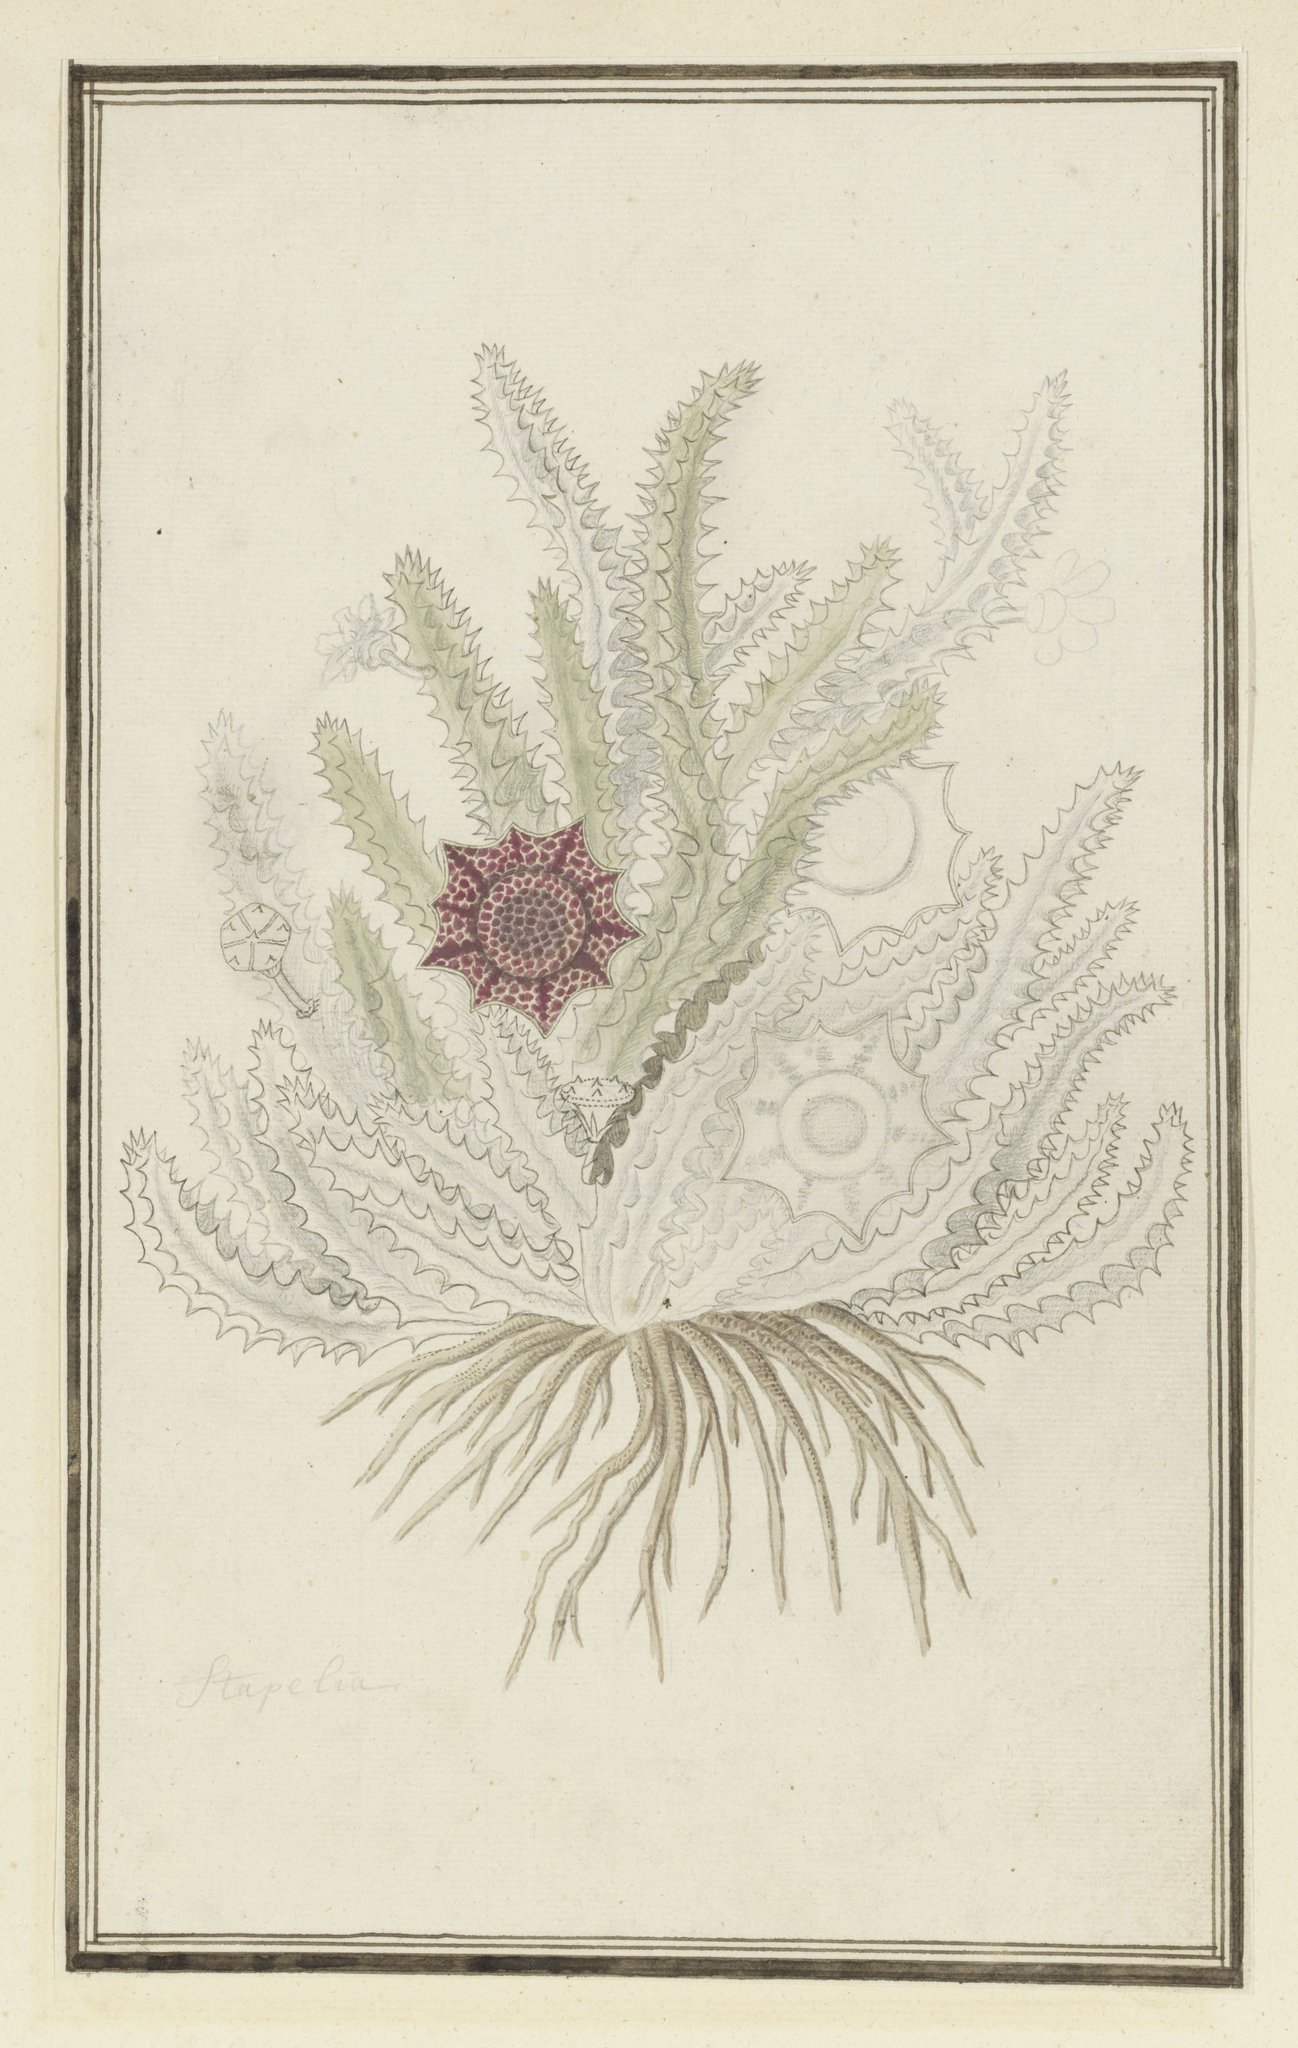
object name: album leaf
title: Huernia guttata (Masson) Haw. (Stapelia guttata)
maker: robert jacob gordon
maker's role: draughtsman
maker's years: 1743-1795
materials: chalk, ink, paper, pencil, watercolor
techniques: brush, pen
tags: plants; vegetation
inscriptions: annotation: ‘Stapelia’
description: De tekening is gemaakt voor of tijdens een van Gordon's vier expedities door de Kaapprovincie, van oktober 1777 tot maart 1786. Sommige (soort)namen kunnen zijn gewijzigd, gezien reorganisatie in plantentaxonomie gedurende de afgelopen jaren.